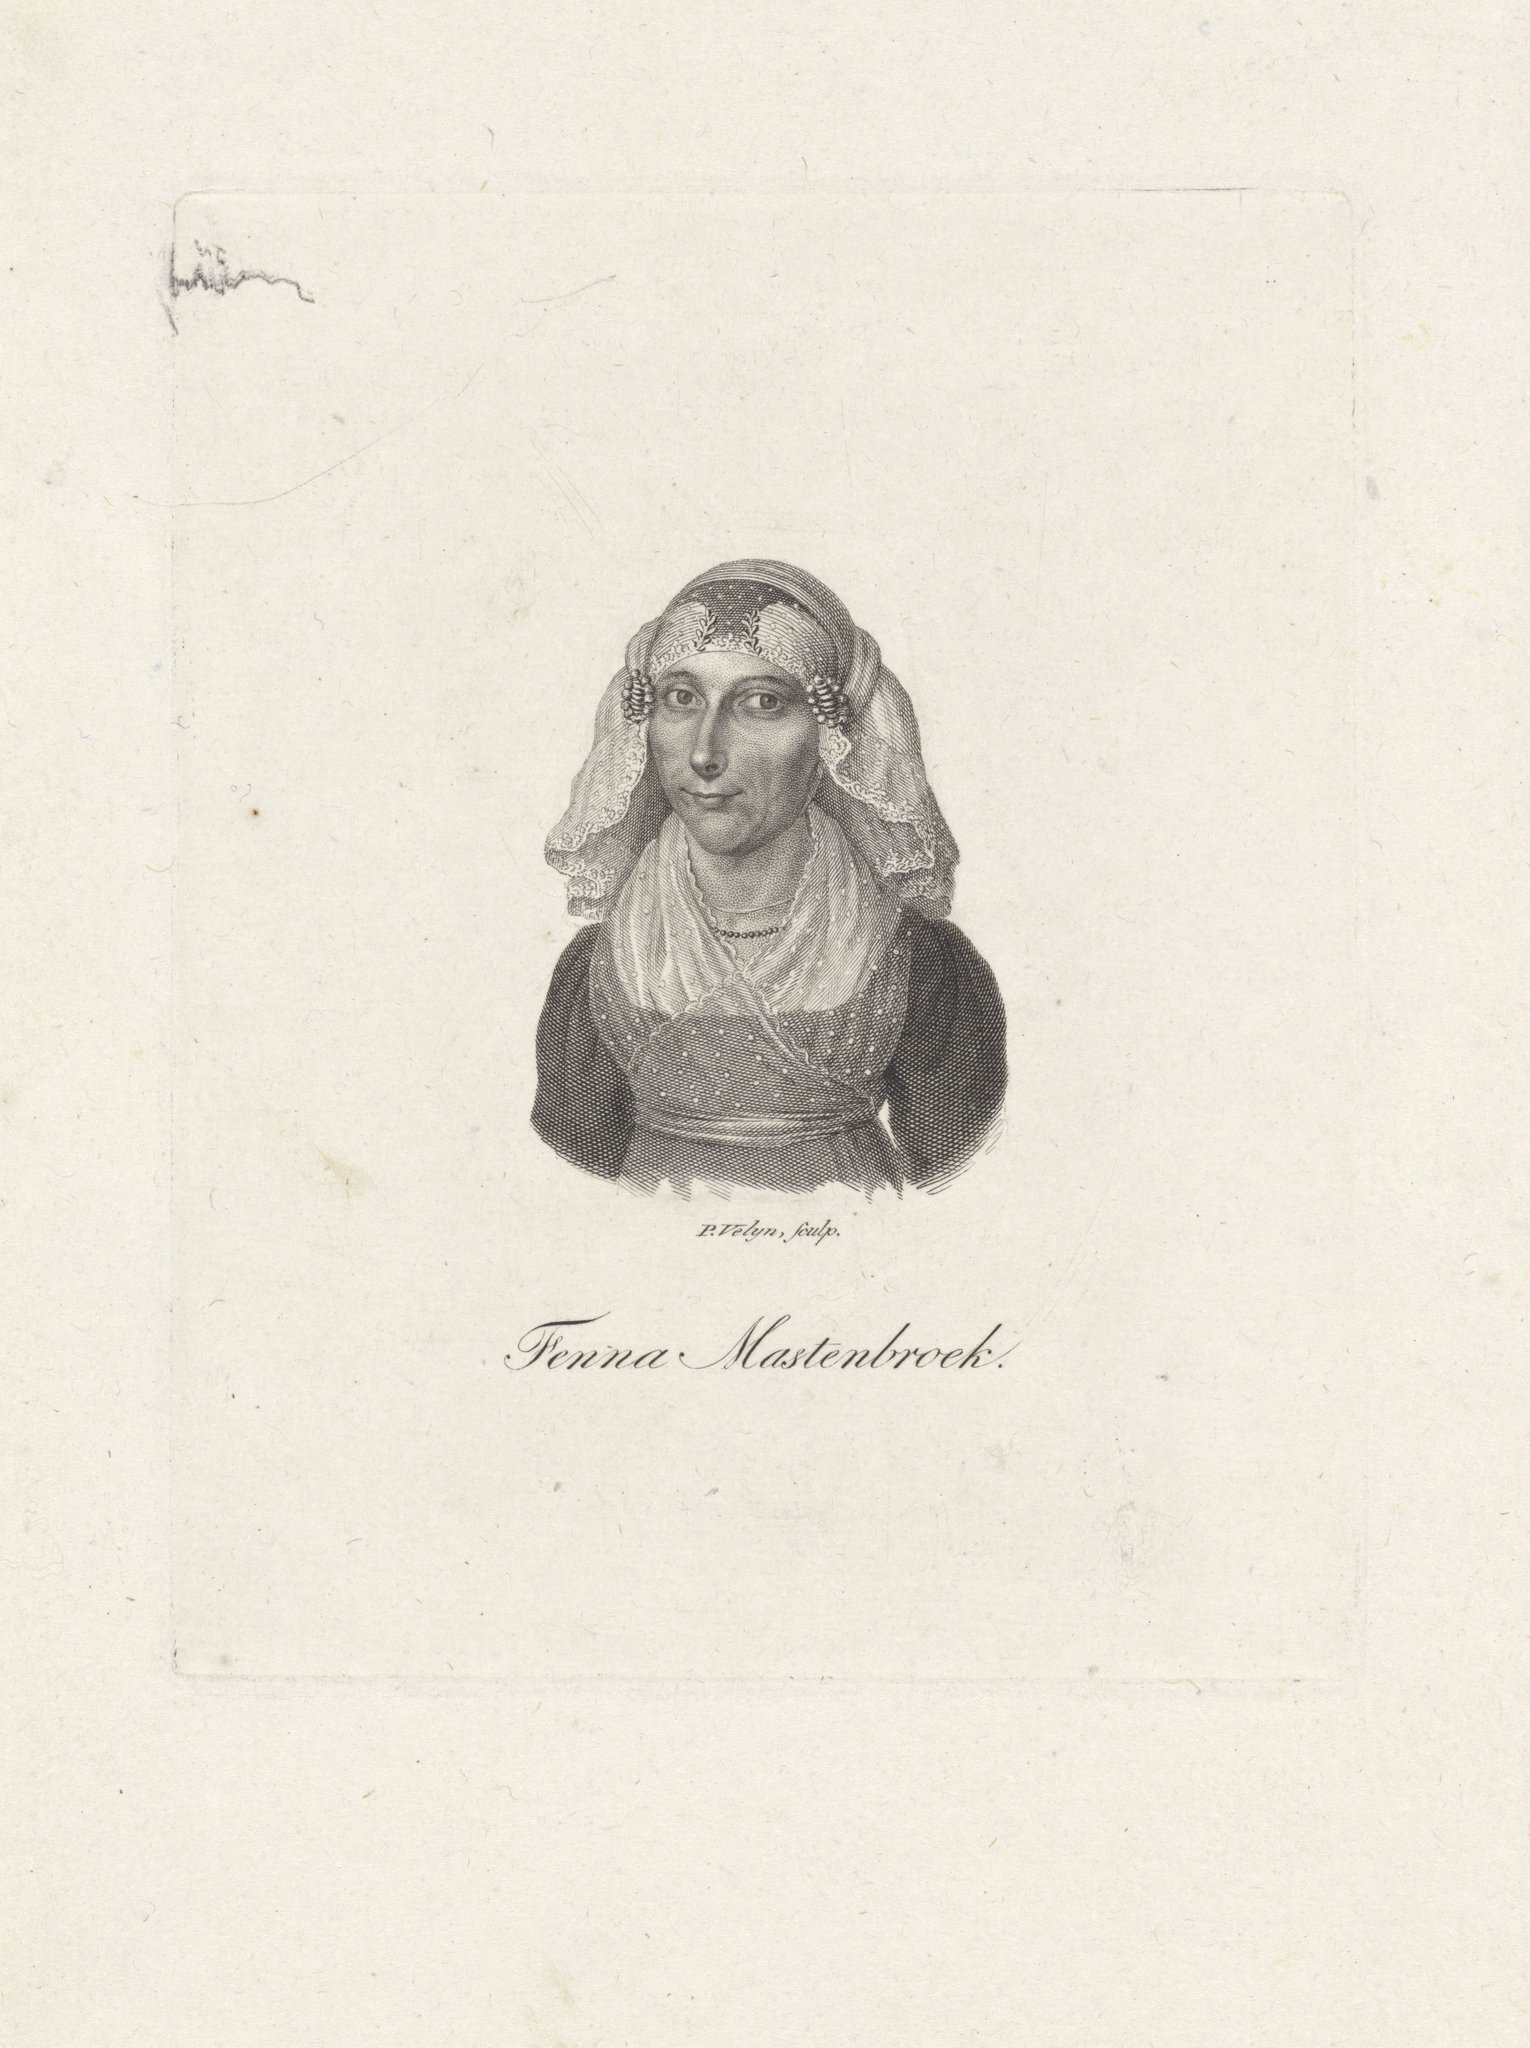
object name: print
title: Portret van Fenna Mastenbroek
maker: philippus velijn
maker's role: print maker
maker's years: 1787-1836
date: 1797-1836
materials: paper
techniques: engraving, etching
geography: netherlands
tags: sneek, dichter, schrijver, fenna mastenbroek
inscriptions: collector's mark: Lugt 2228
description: Portret van Fenna Mastenbroek, schrijfster en dichteres te Harlingen.